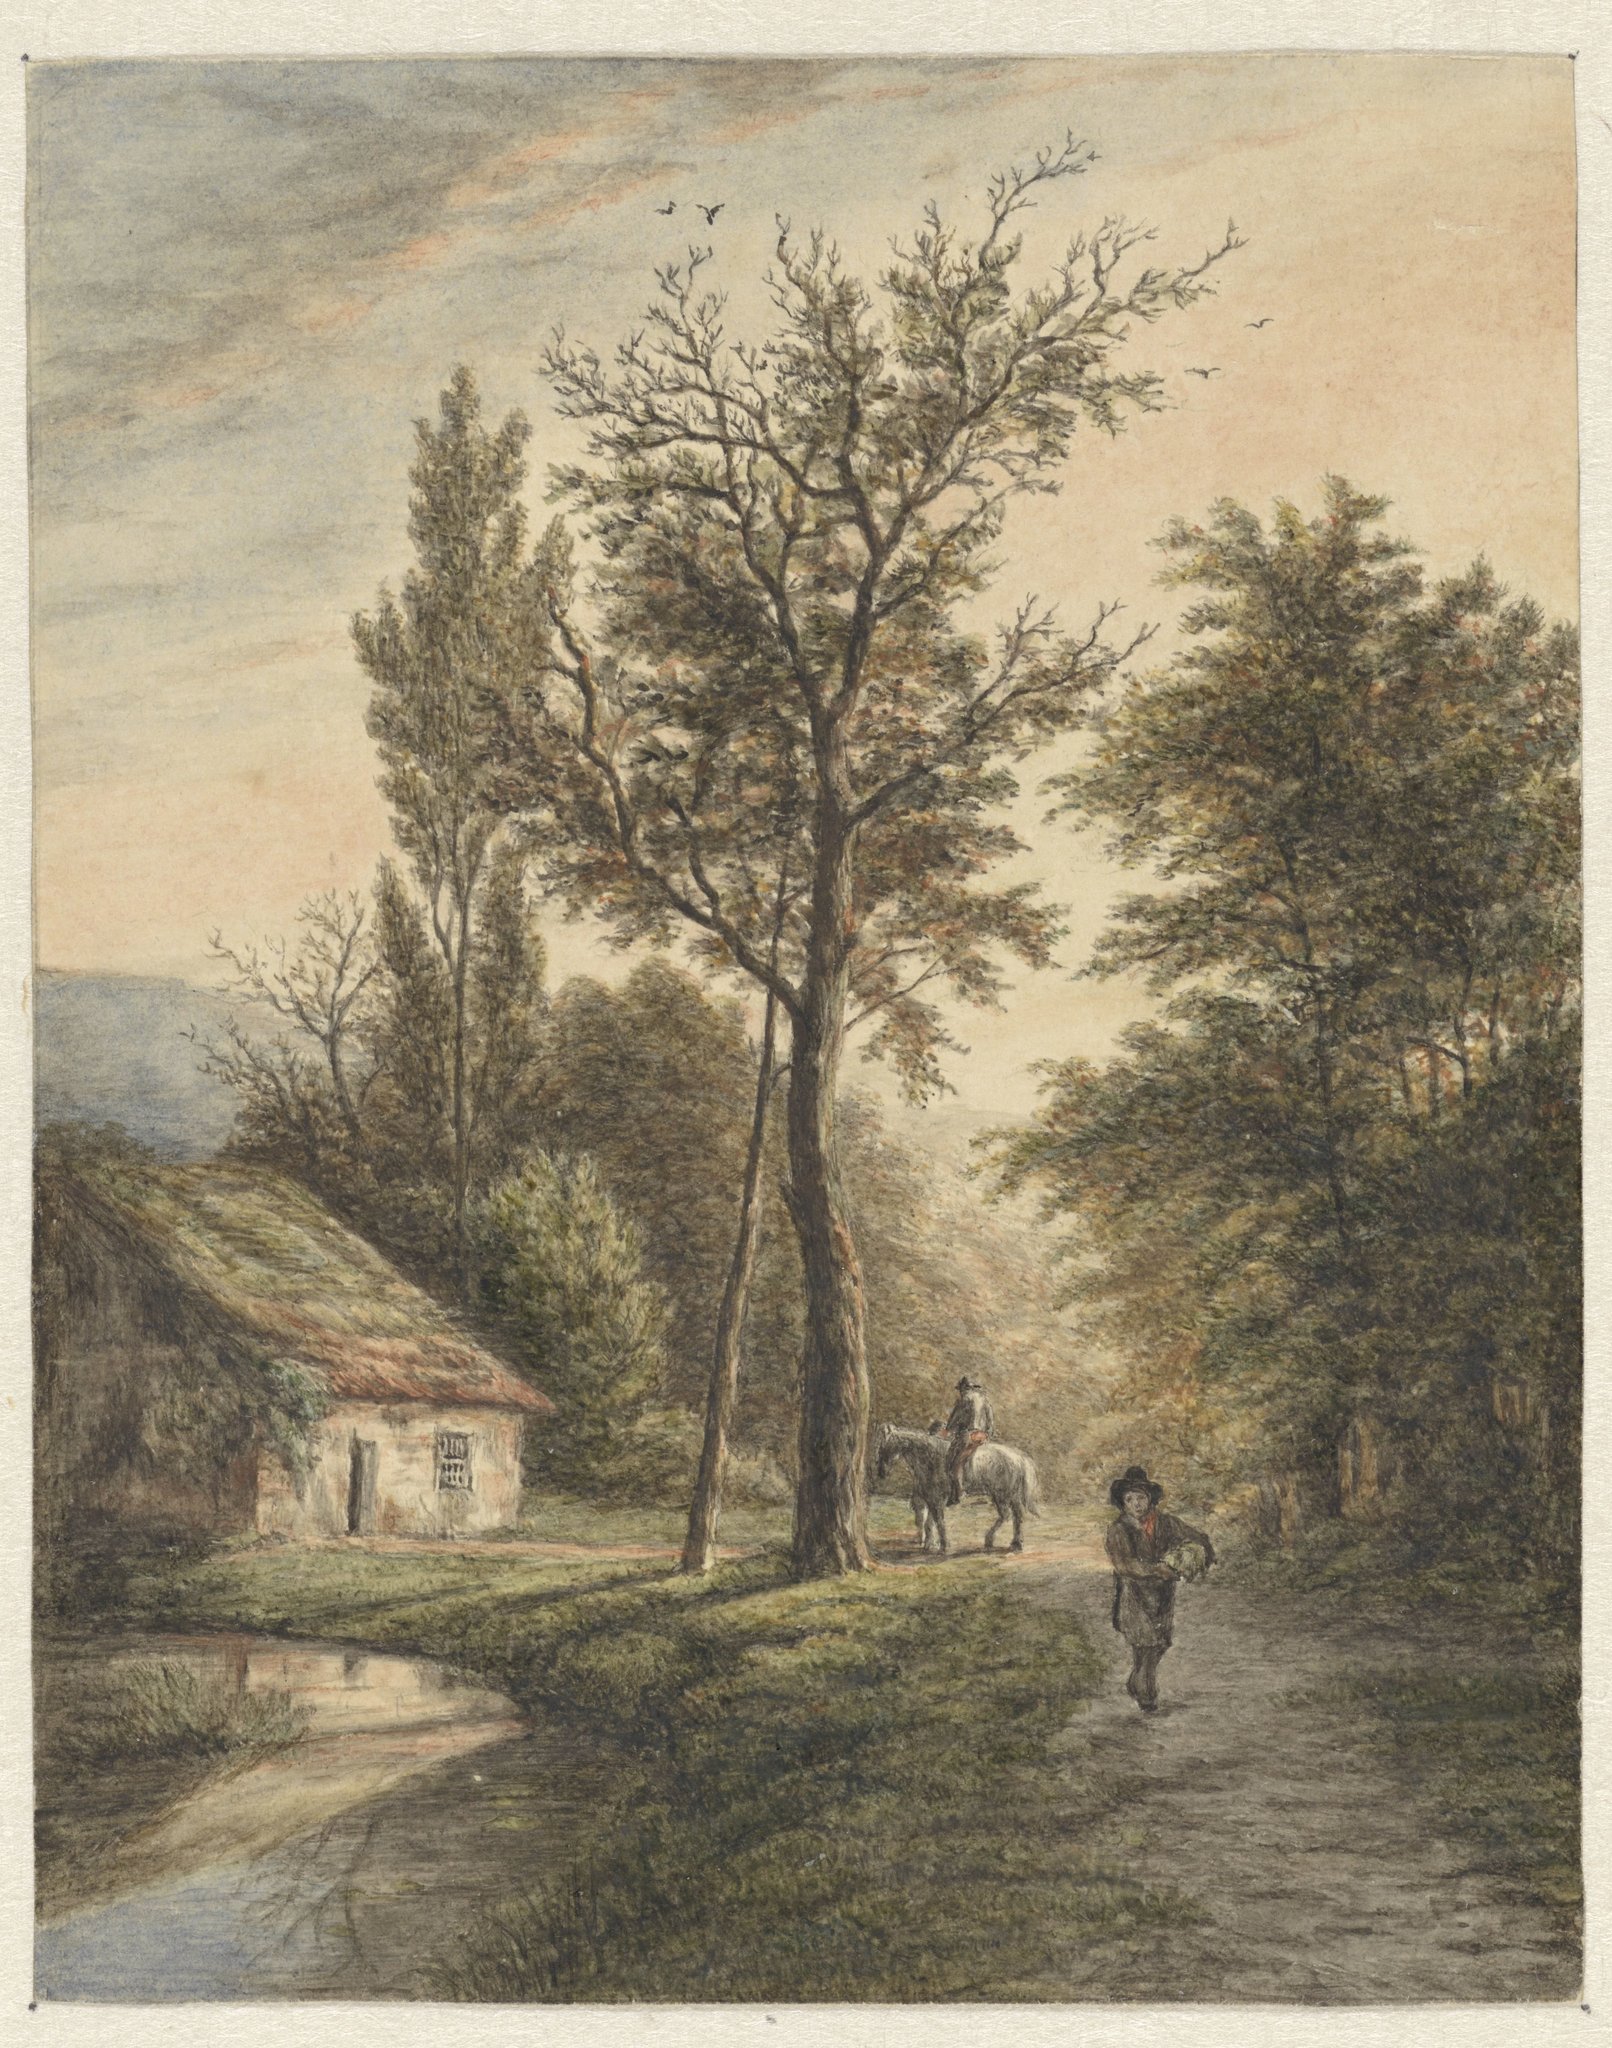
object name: watercolor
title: Landschap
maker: matthijs maris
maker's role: draughtsman, painter, print maker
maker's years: 1839-1917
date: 1849-1917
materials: paper, watercolor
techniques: brush